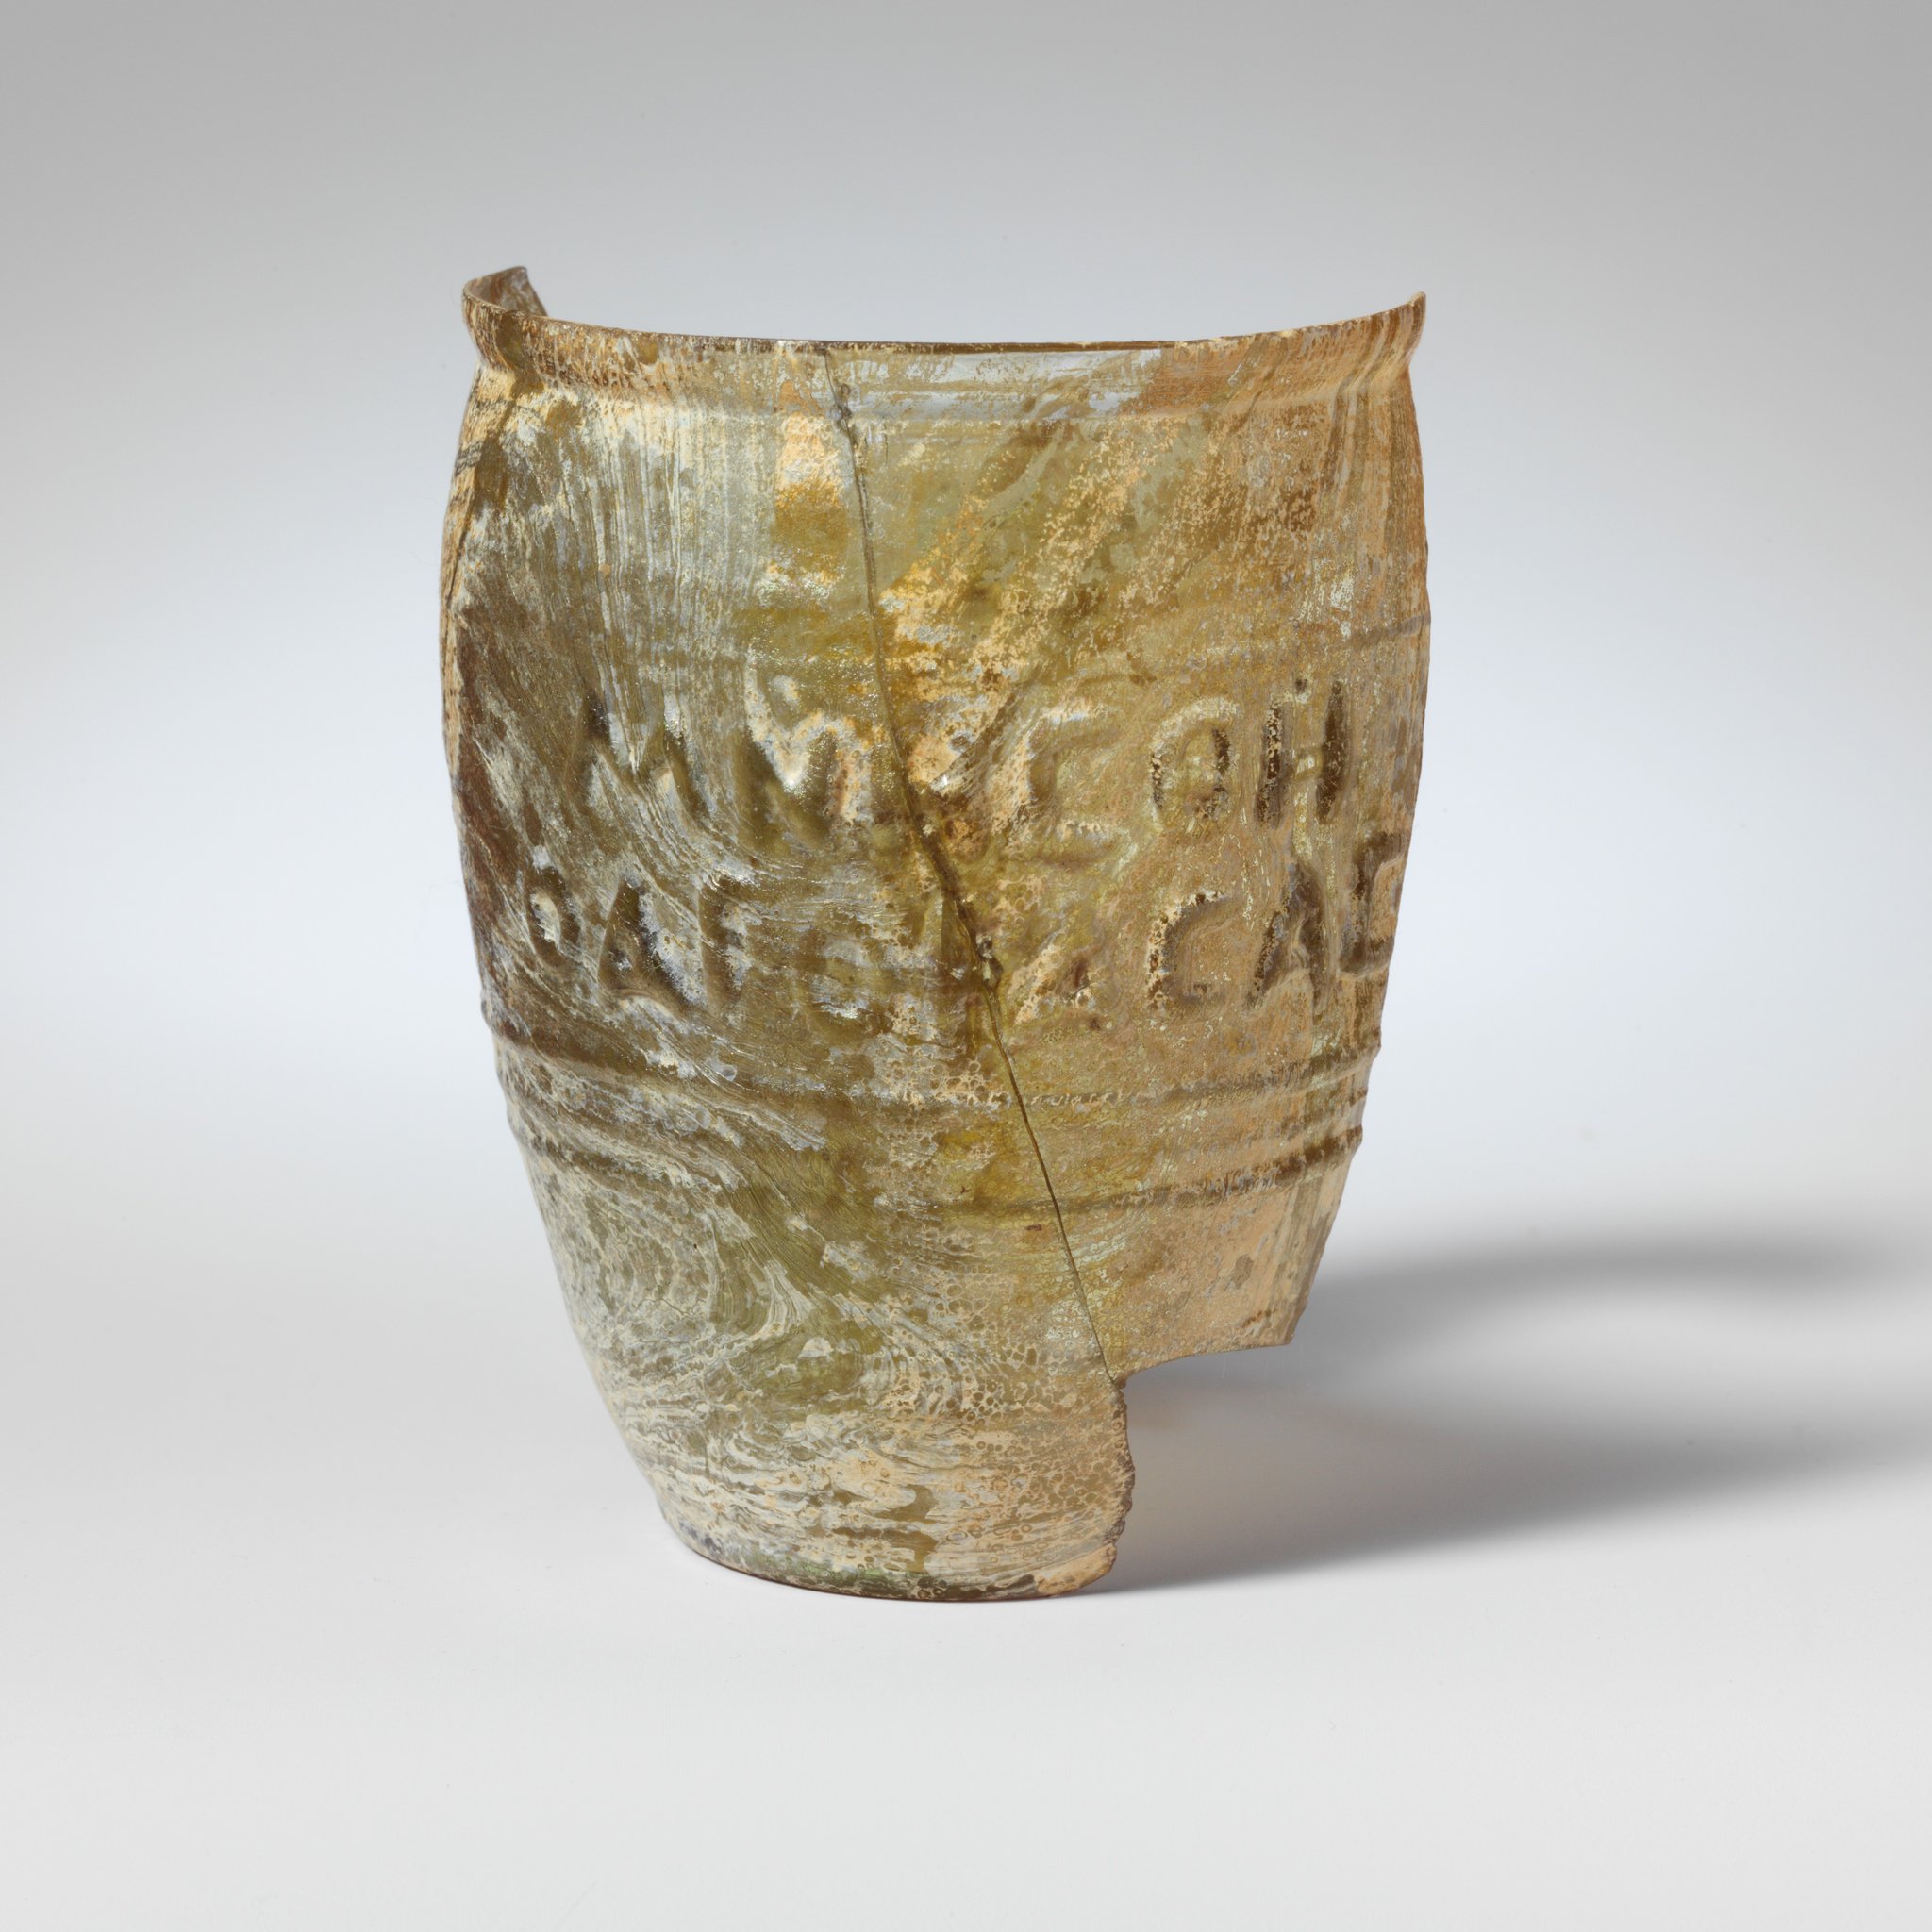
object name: beaker, fragmentary, signed by neikais.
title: Glass beaker signed by Neikais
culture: roman, syro-palestinian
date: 34-66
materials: glass